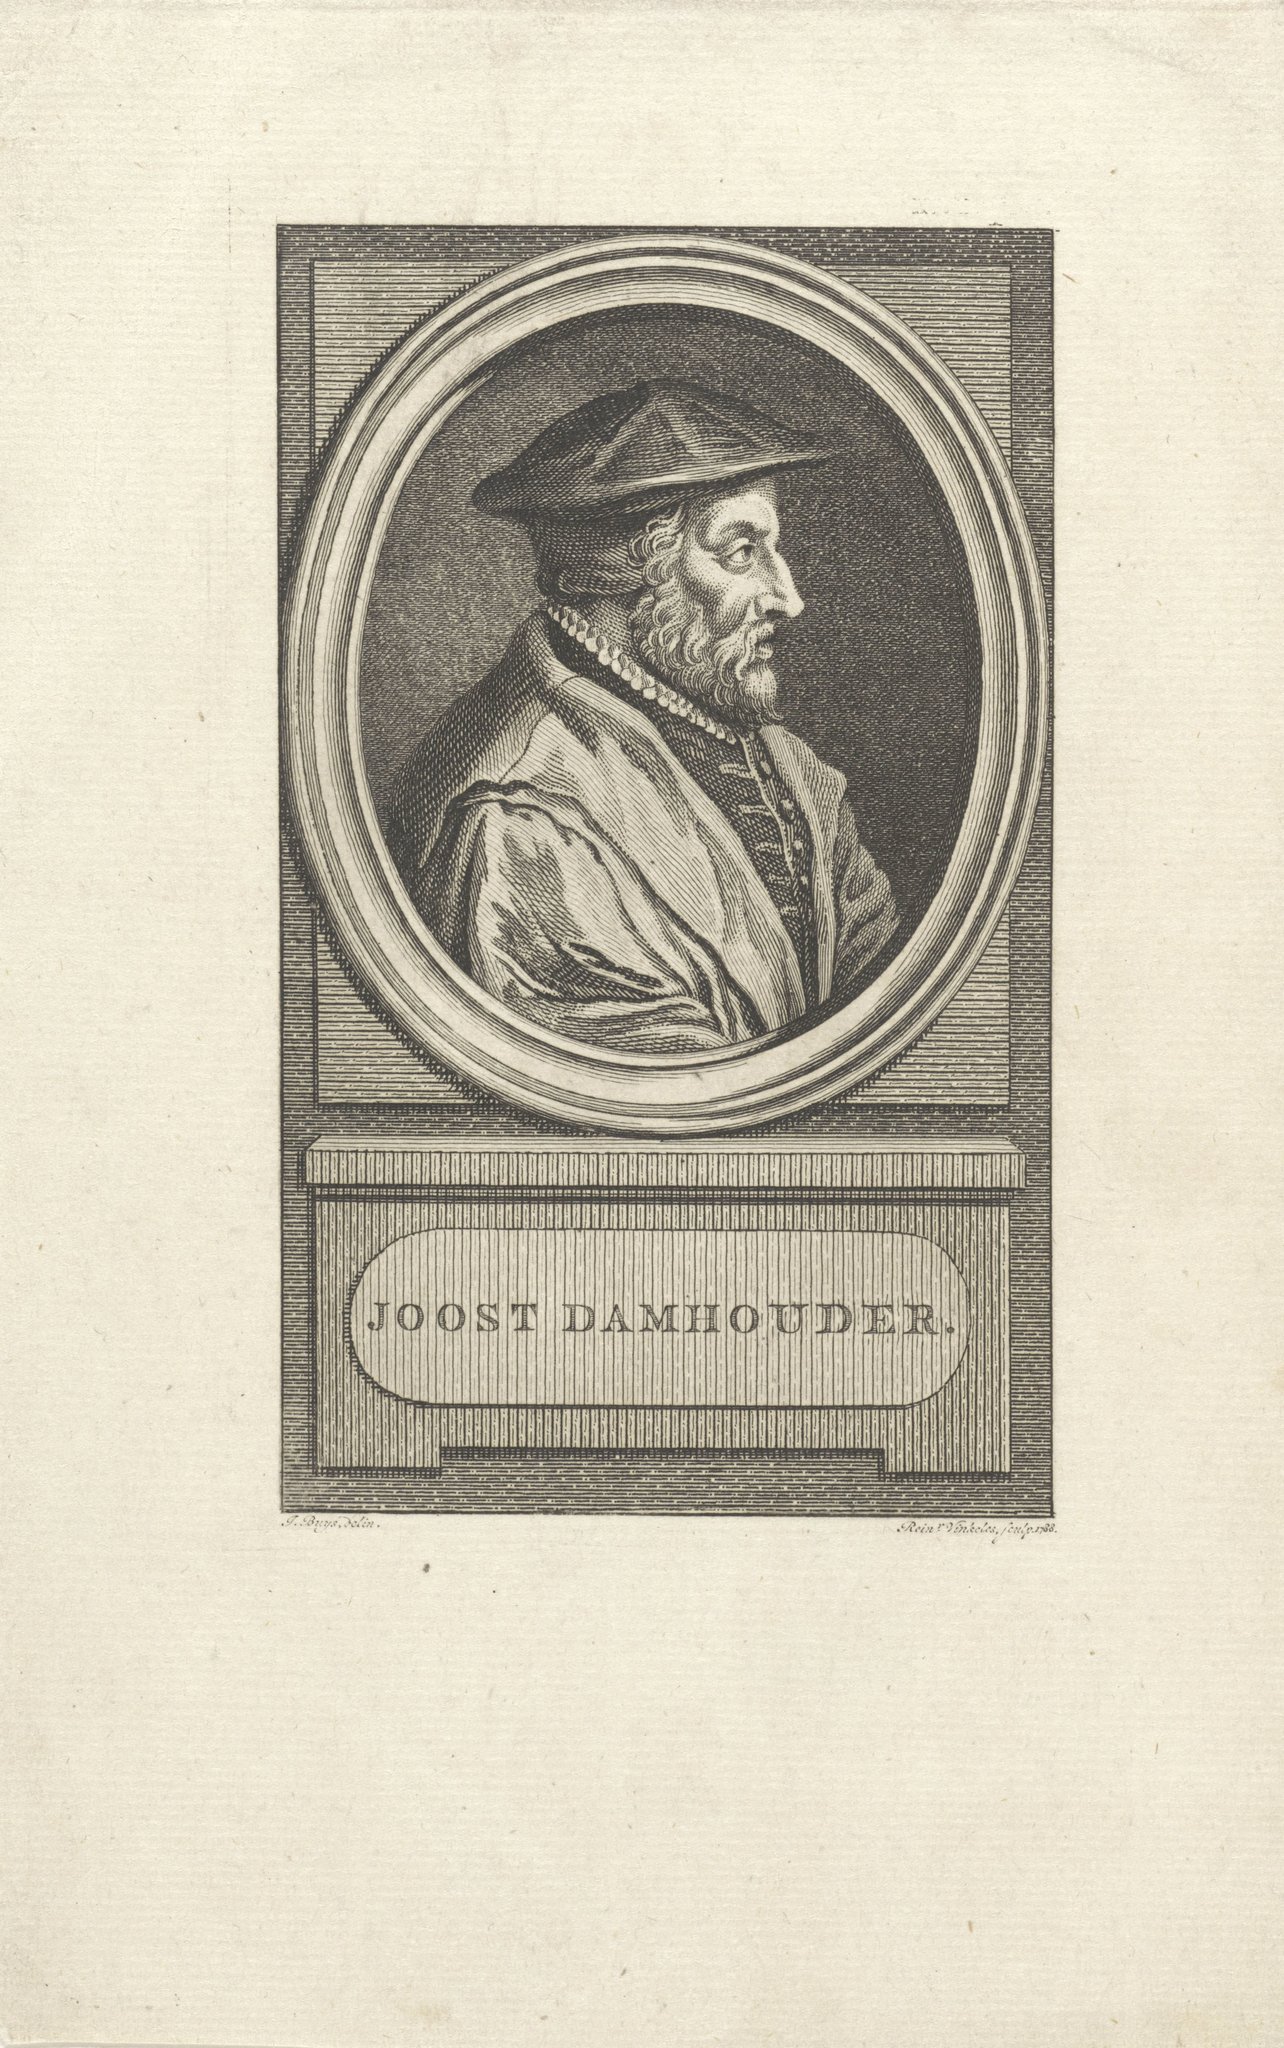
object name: print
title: Portret van Joos de Damhouder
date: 1788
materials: paper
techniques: etching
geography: amsterdam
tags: antwerp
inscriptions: collector's mark: Lugt 2228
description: Andere staat prent gebruikt als boekillustratie in: Kok, Jacobus. Vaderlandsch woordenboek : met kaarten, plaaten en pourtraitten. Amsterdam: Johannes Allart, 1785-1796. Deel XI.